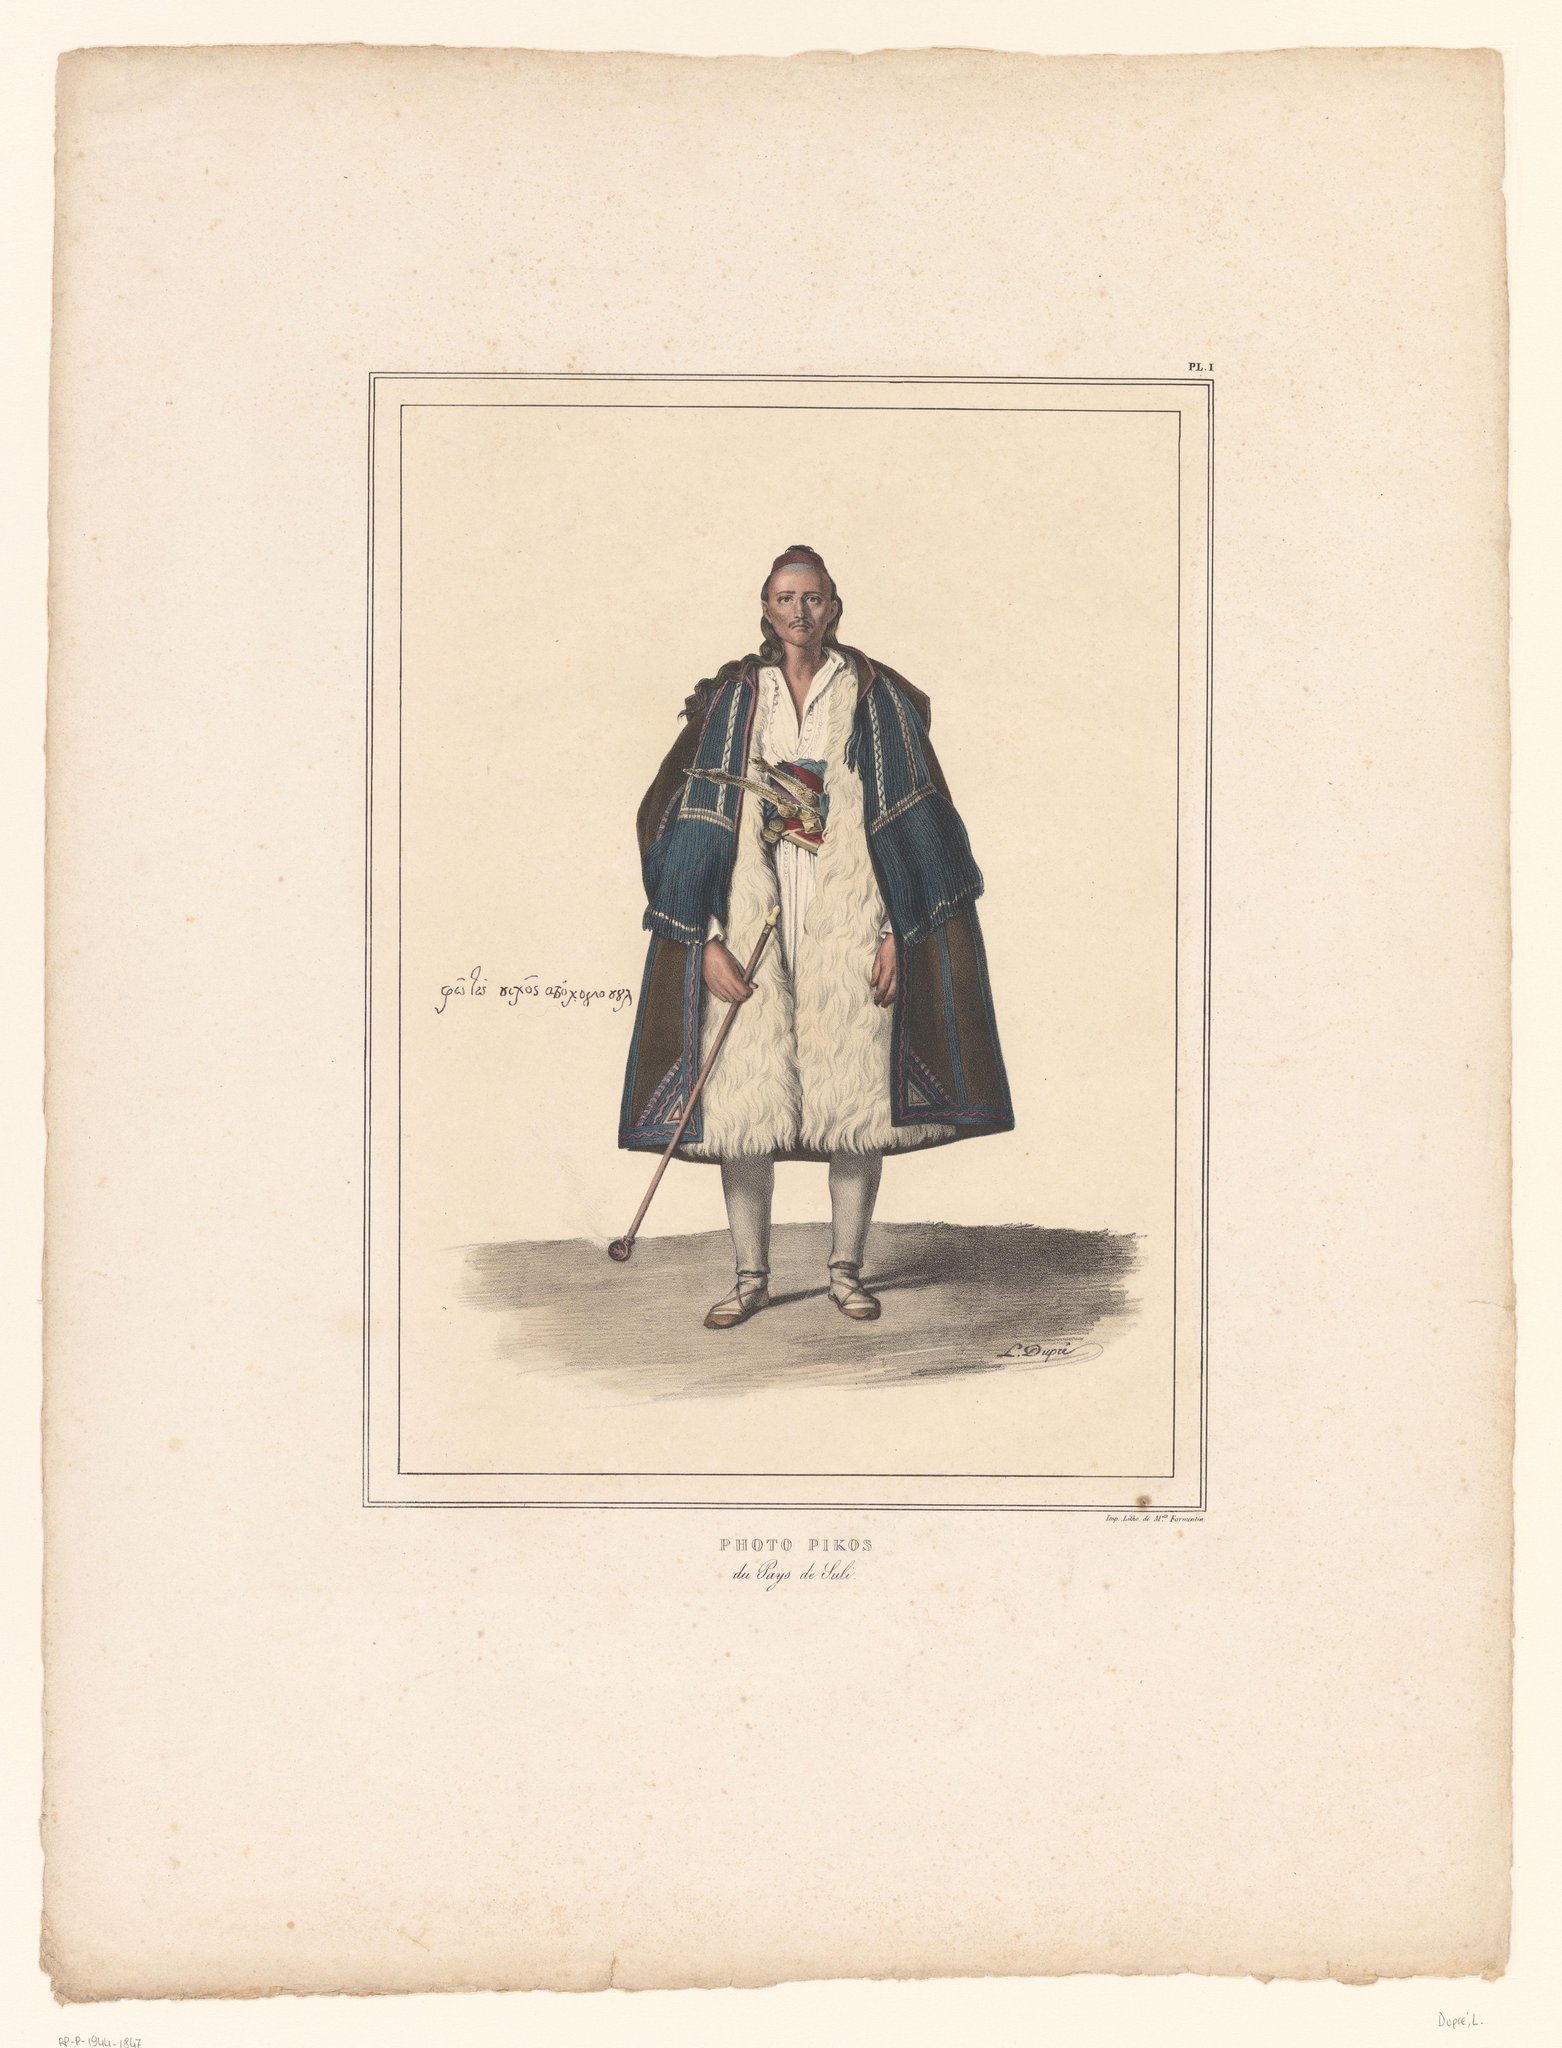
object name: print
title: Portret van Photo Pikos uit Souli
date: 1825-1839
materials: paper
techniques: hand coloring, lithograph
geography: paris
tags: historical persons, pipe ~ tobacco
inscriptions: watermark: ‘103’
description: De prent maakt deel uit van de serie 'Voyage à Athènes et à Constantinople ou collection de portraits, de vues et de costumes Grecs et Ottomans' die tussen 1825 en 1839 in tien delen van vier prenten werd uitgebracht. De in totaal veertig prenten dienden samen met een tekst van 52 pagina's voorzien van vignettes als een verslag van de reis die Louis Dupré in 1819 naar Athene en het huidige Istanboel maakte (zie documentatie).